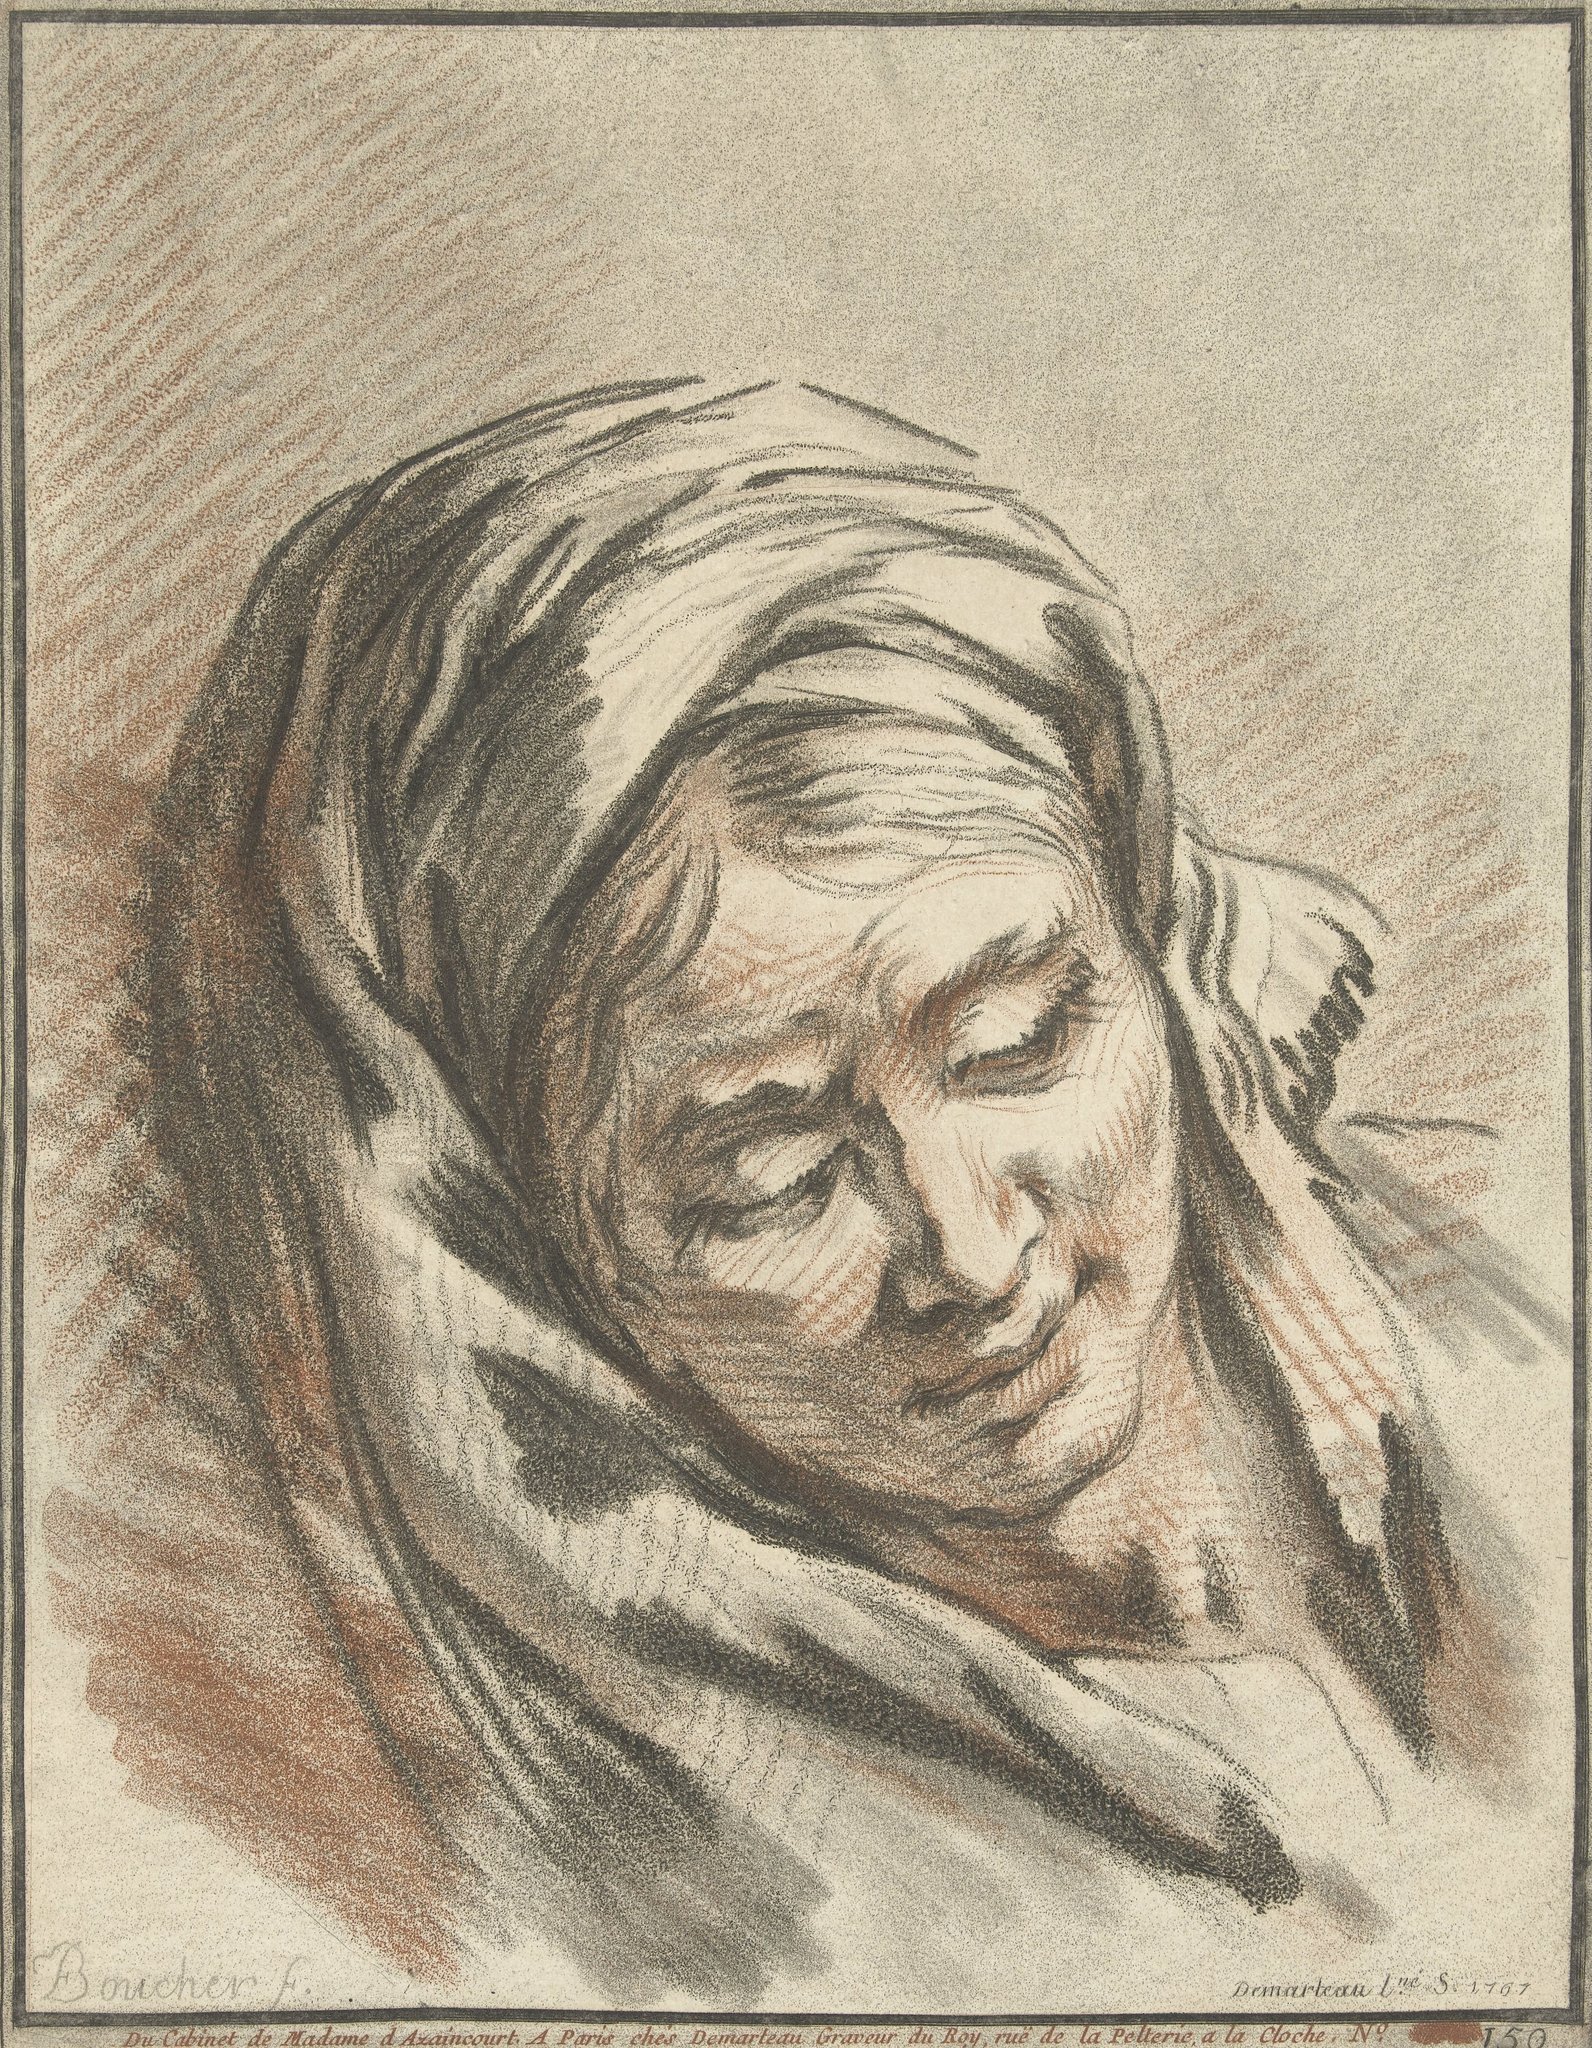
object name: print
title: Hoofd van vrouw met hoofddoek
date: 1767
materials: paper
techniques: printmaking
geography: paris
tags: drapery, draped garment, 'gewandgebung'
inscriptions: collector's mark: Lugt 2228